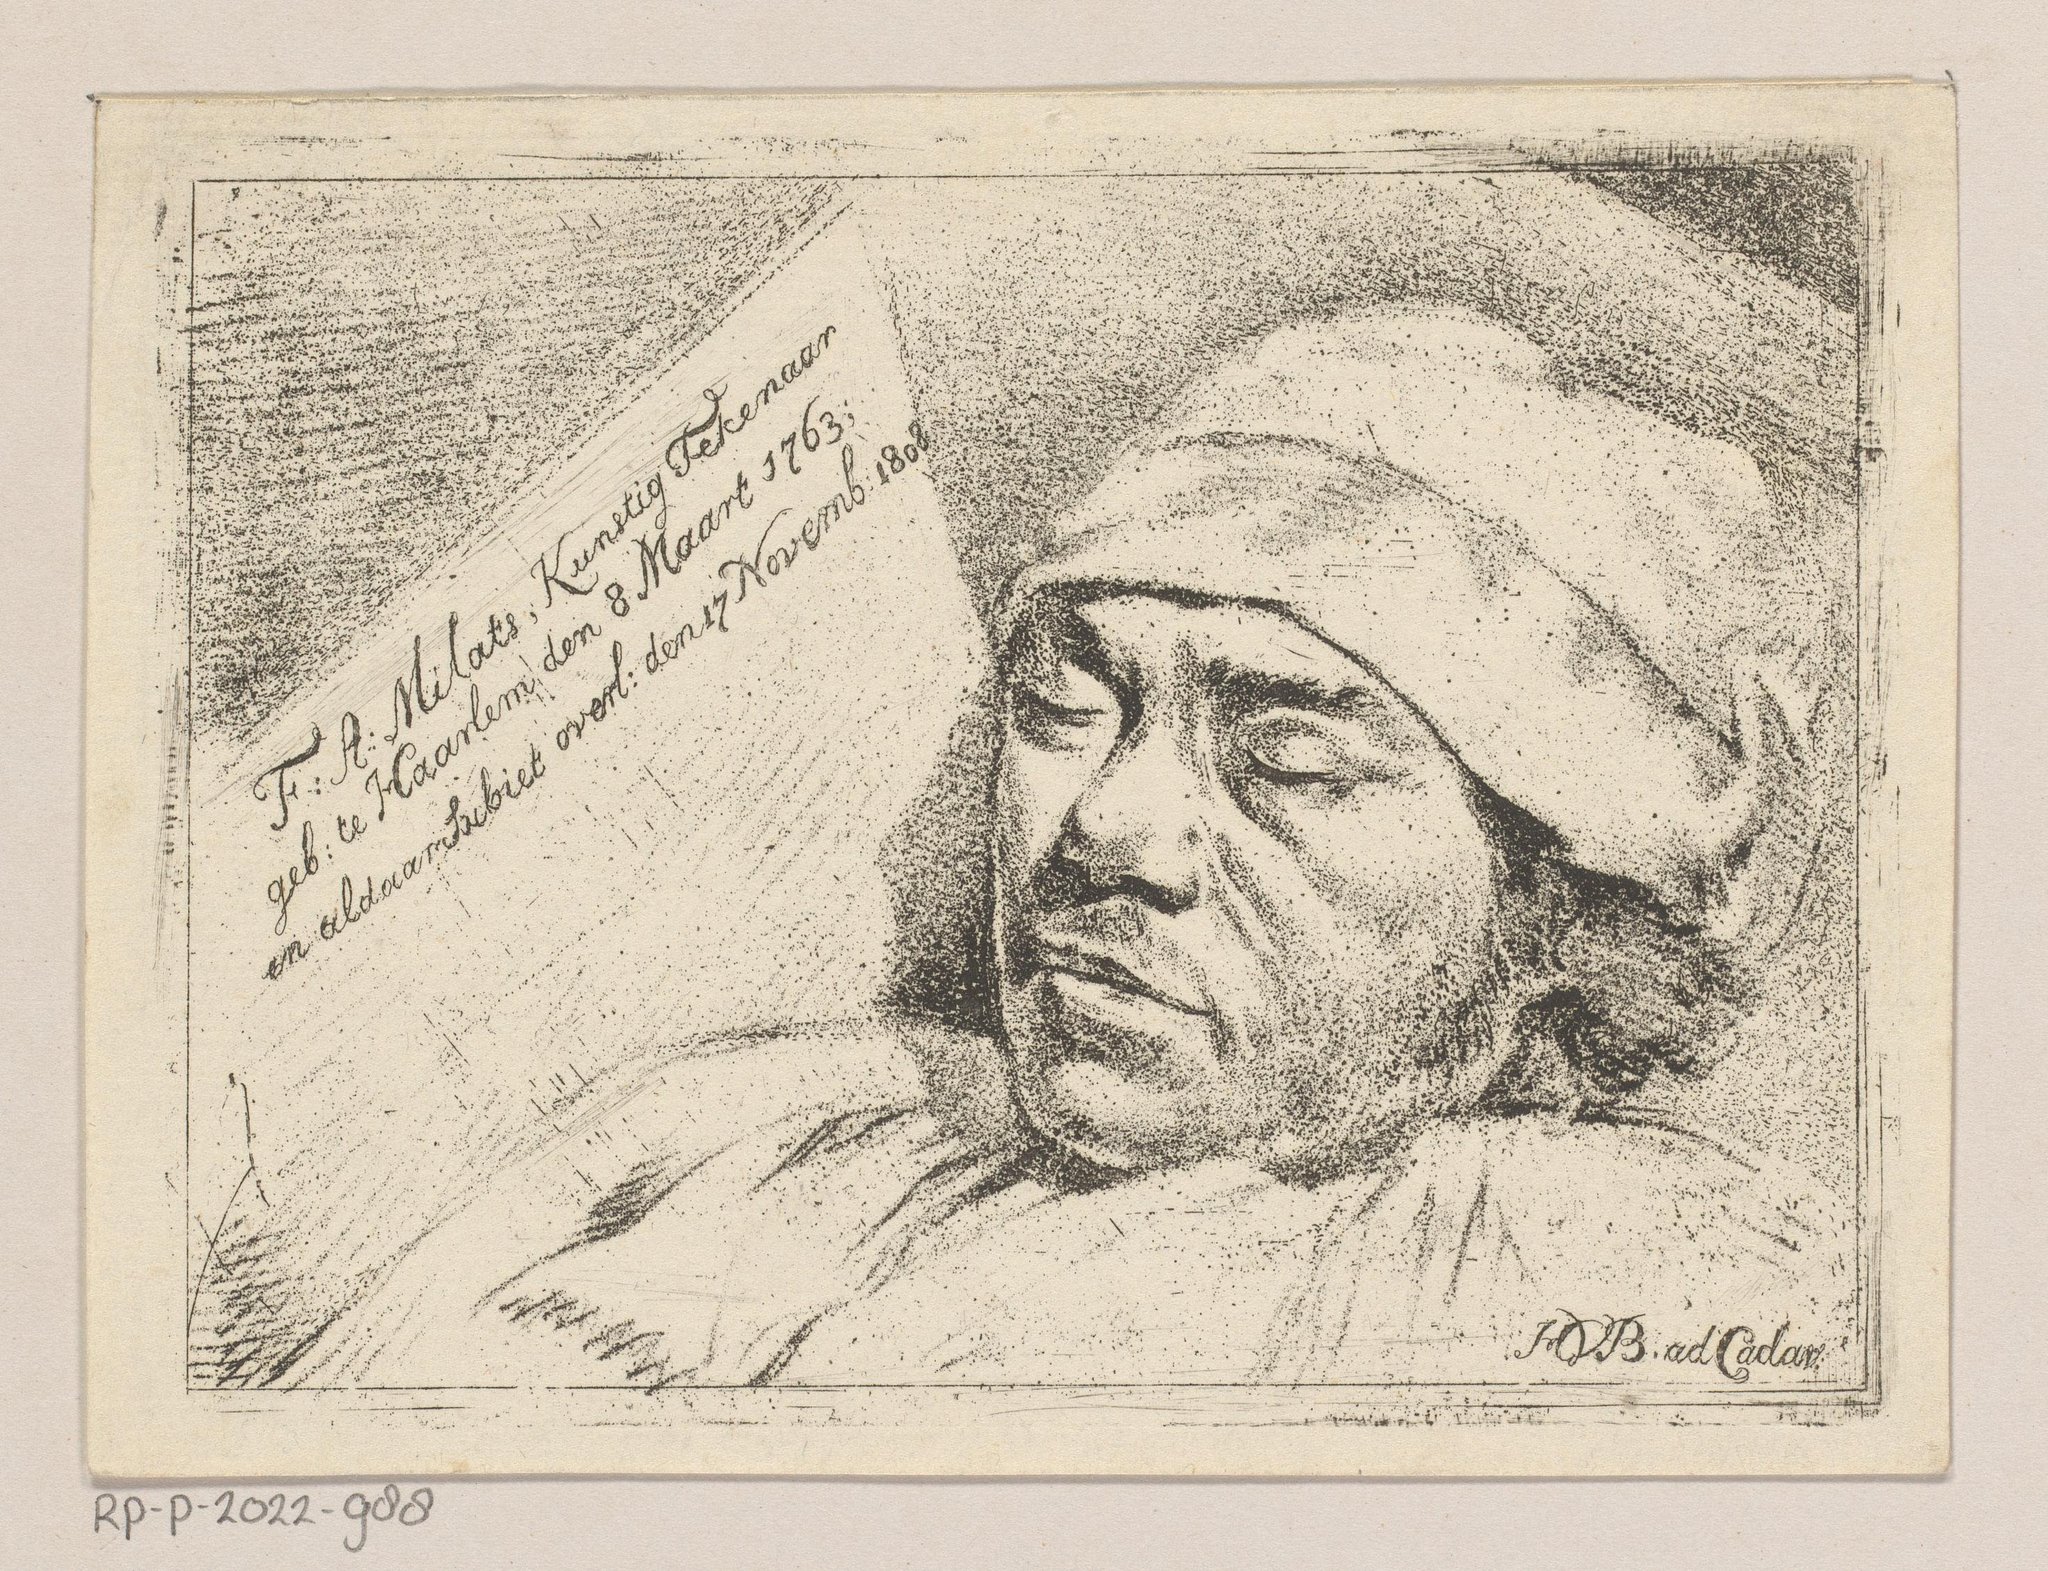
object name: print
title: Portret van Franciscus Andreas Milatz op zijn doodsbed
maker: hermanus van brussel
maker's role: draughtsman, print maker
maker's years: 1763-1815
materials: paper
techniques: soft ground etching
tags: painter, franciscus andreas milatz, historical persons, artist on his deathbed